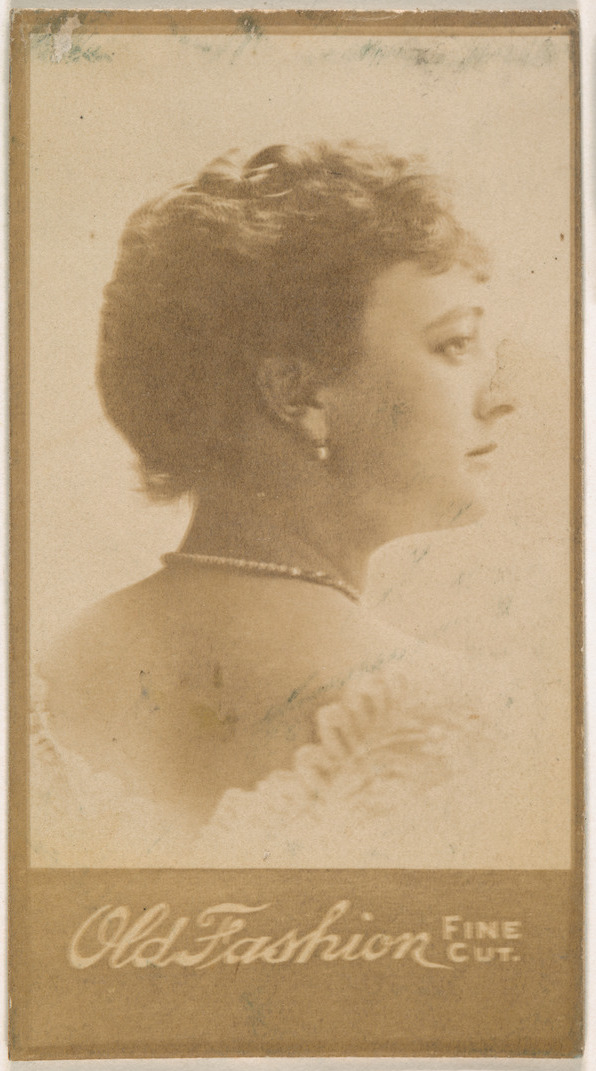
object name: photograph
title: Portrait of actress in profile, from the Actresses series (N664) promoting Old Fashion Fine Cut Tobacco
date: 1888-1890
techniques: albumen silver print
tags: portraits,profiles,women,actresses